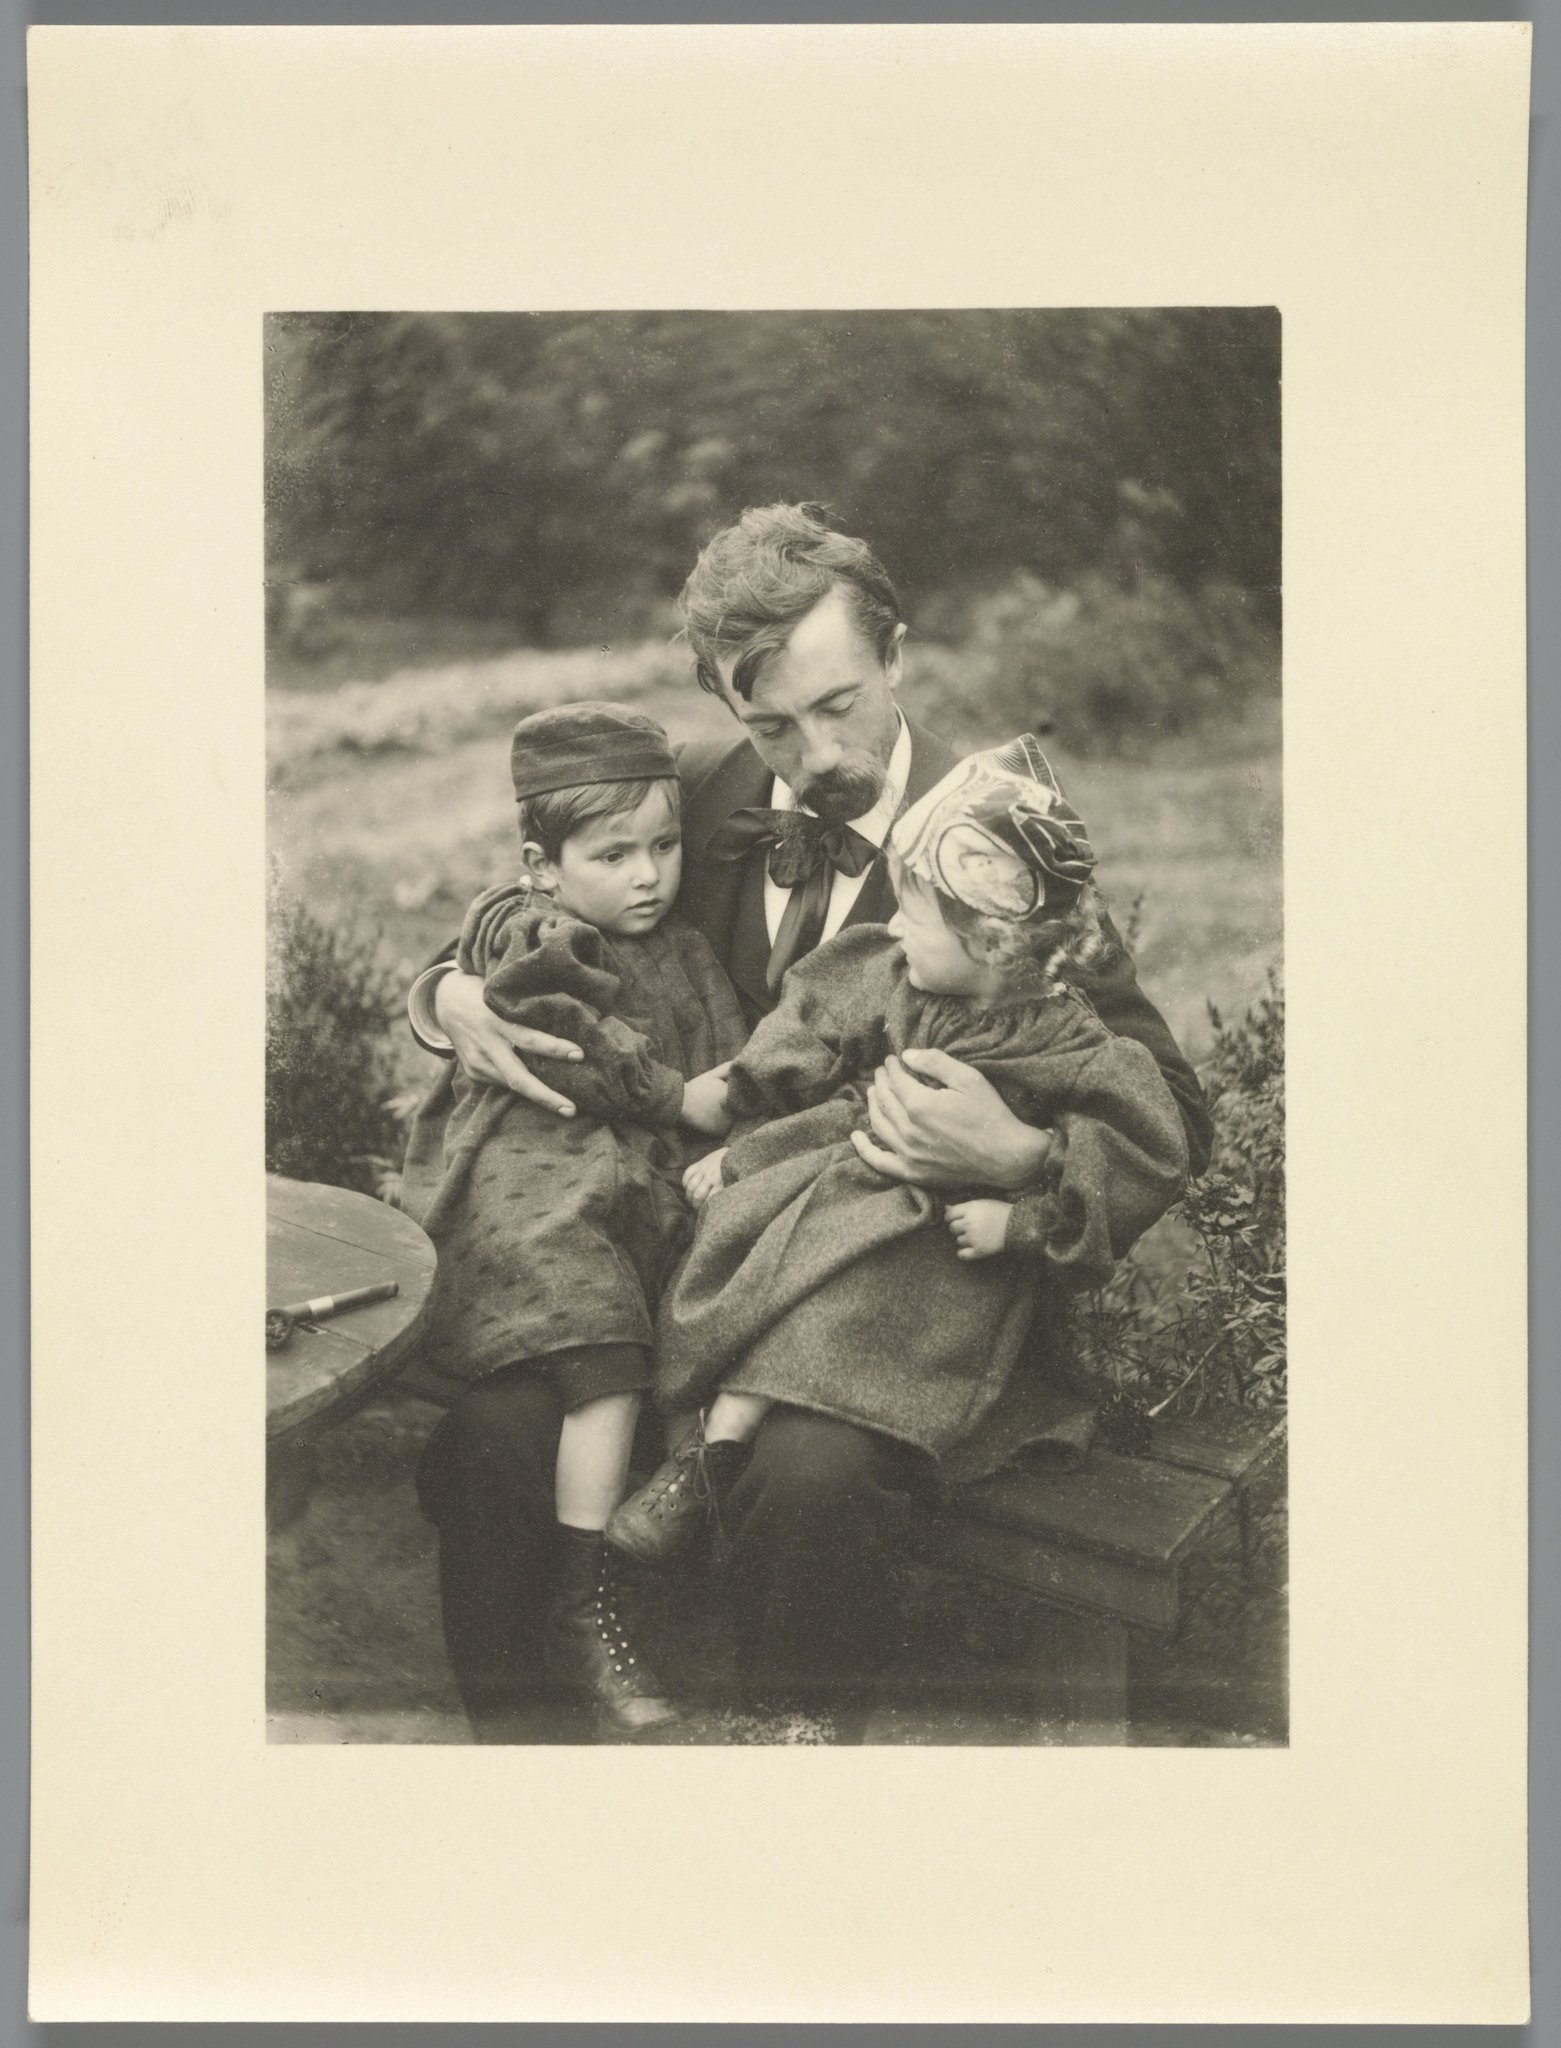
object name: photograph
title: Reproductie naar een foto van Willem Witsen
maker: Anonymous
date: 1860-1915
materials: paper, photographic support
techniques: gelatin silver print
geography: netherlands